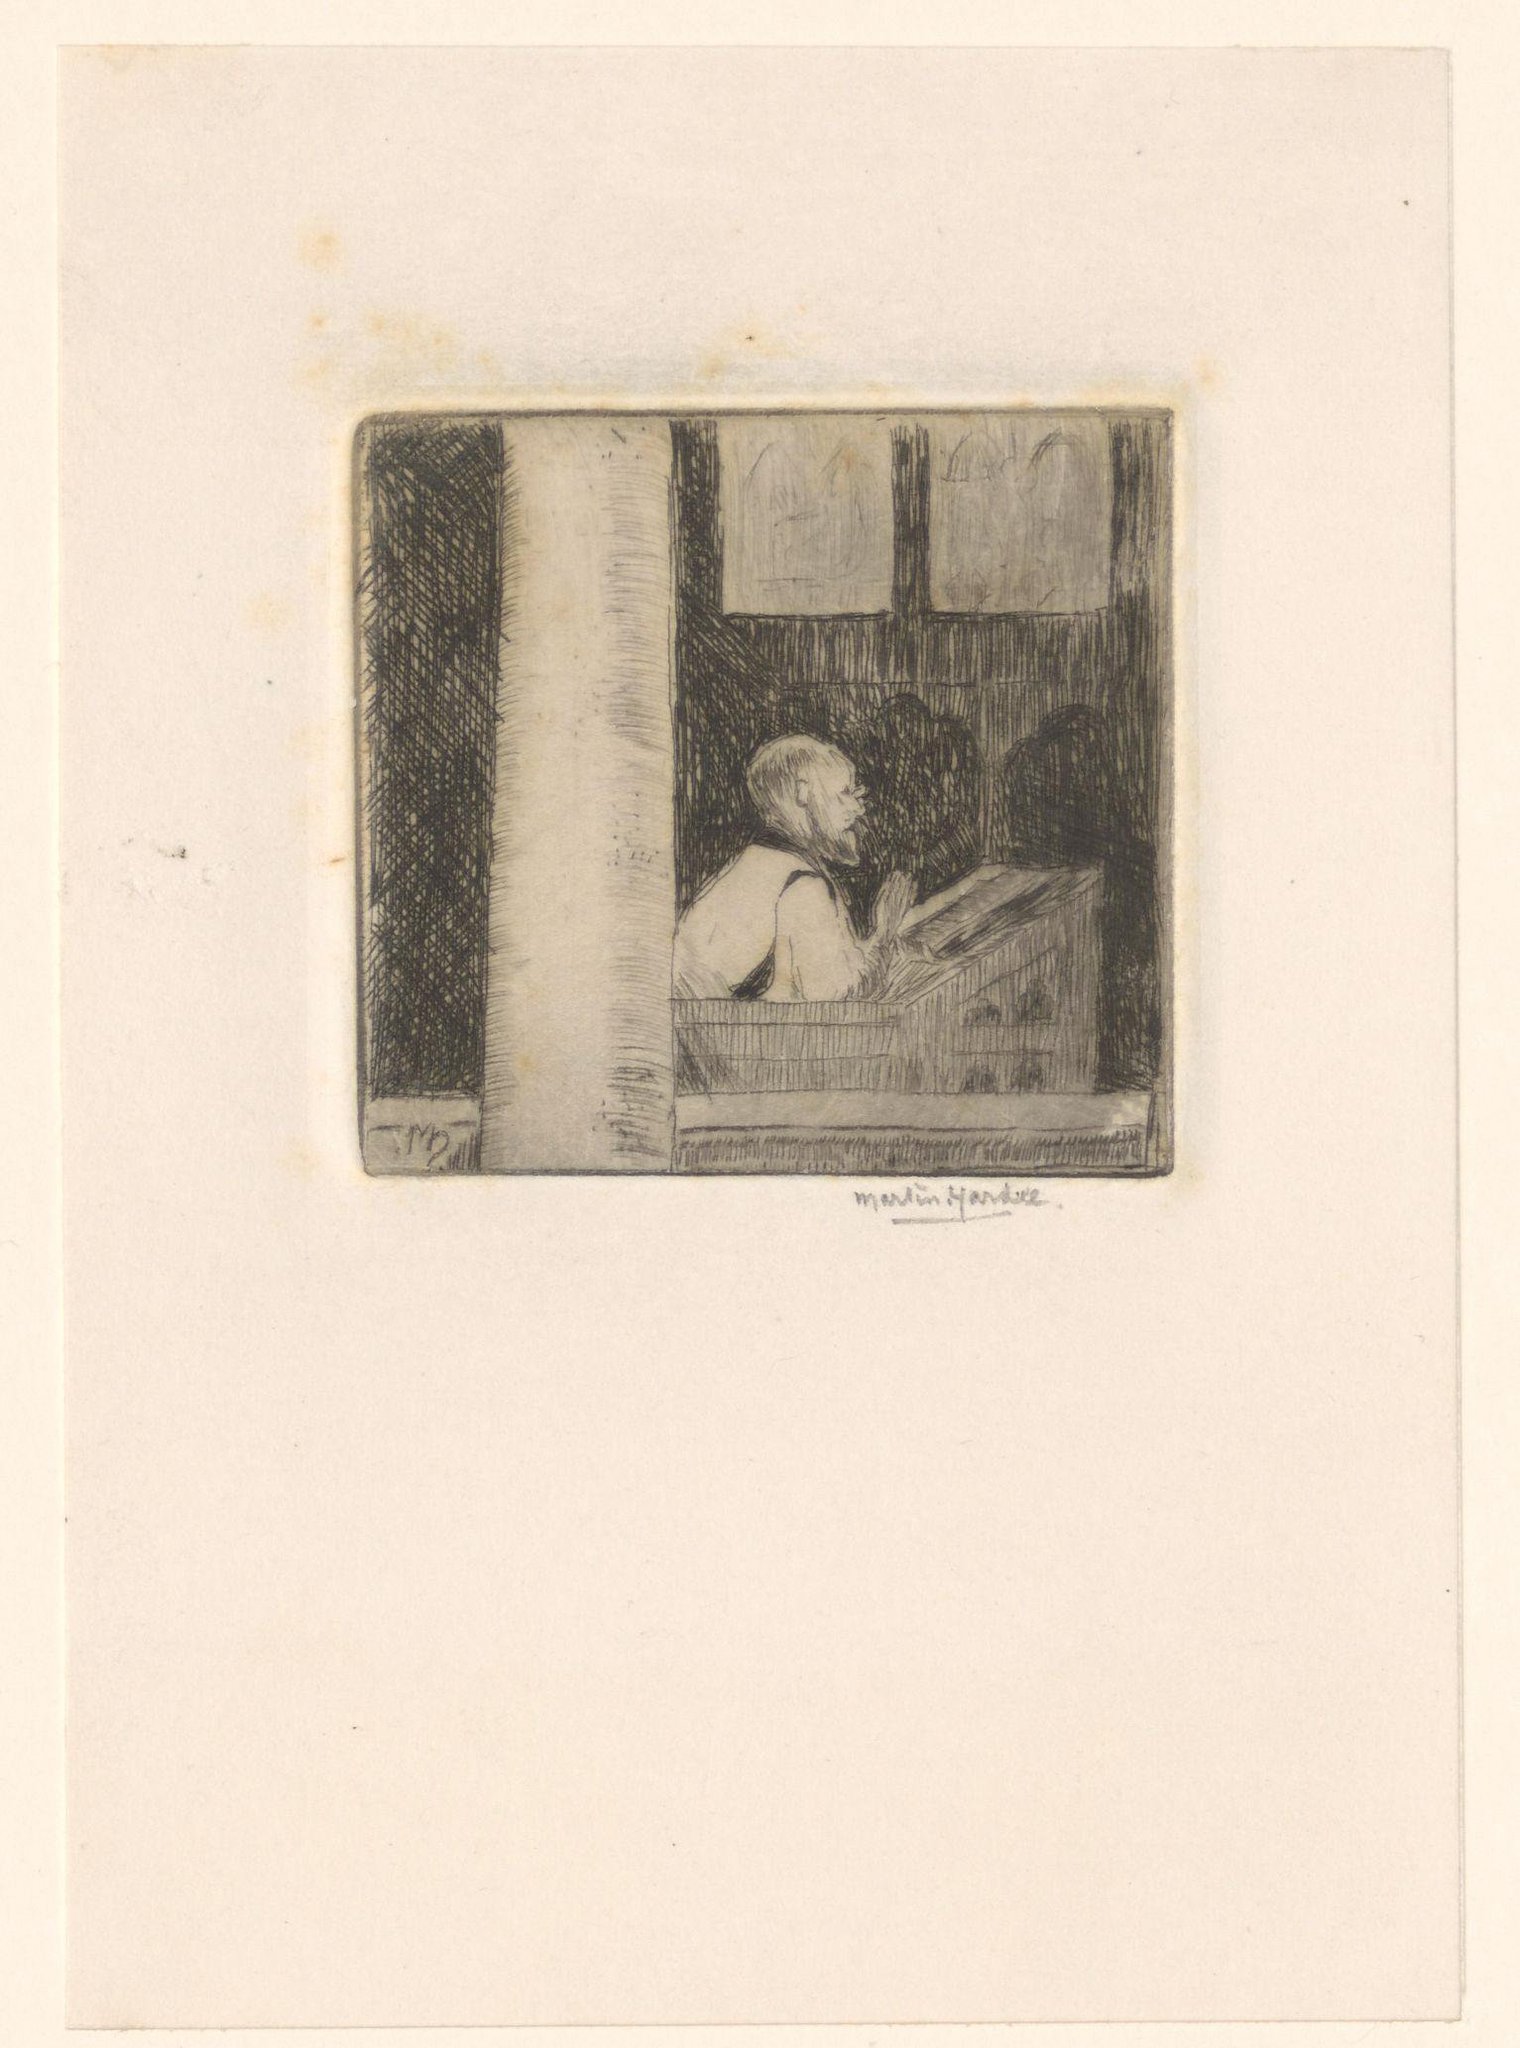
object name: print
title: The Parson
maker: martin hardie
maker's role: print maker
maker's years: 1875-1952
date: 1906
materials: paper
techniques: etching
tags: functionaries and dignitaries (with name) ~ protestant churches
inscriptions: collector's mark: Lugt 2760, annotation: ‘Martin Hardie’, collector's mark: Lugt 2228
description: In de catalogus, gebaseerd op Martin Hardie's eigen notities, staat dat deze prent gemaakt is naar een schets uit zijn eigen gebedenboek.